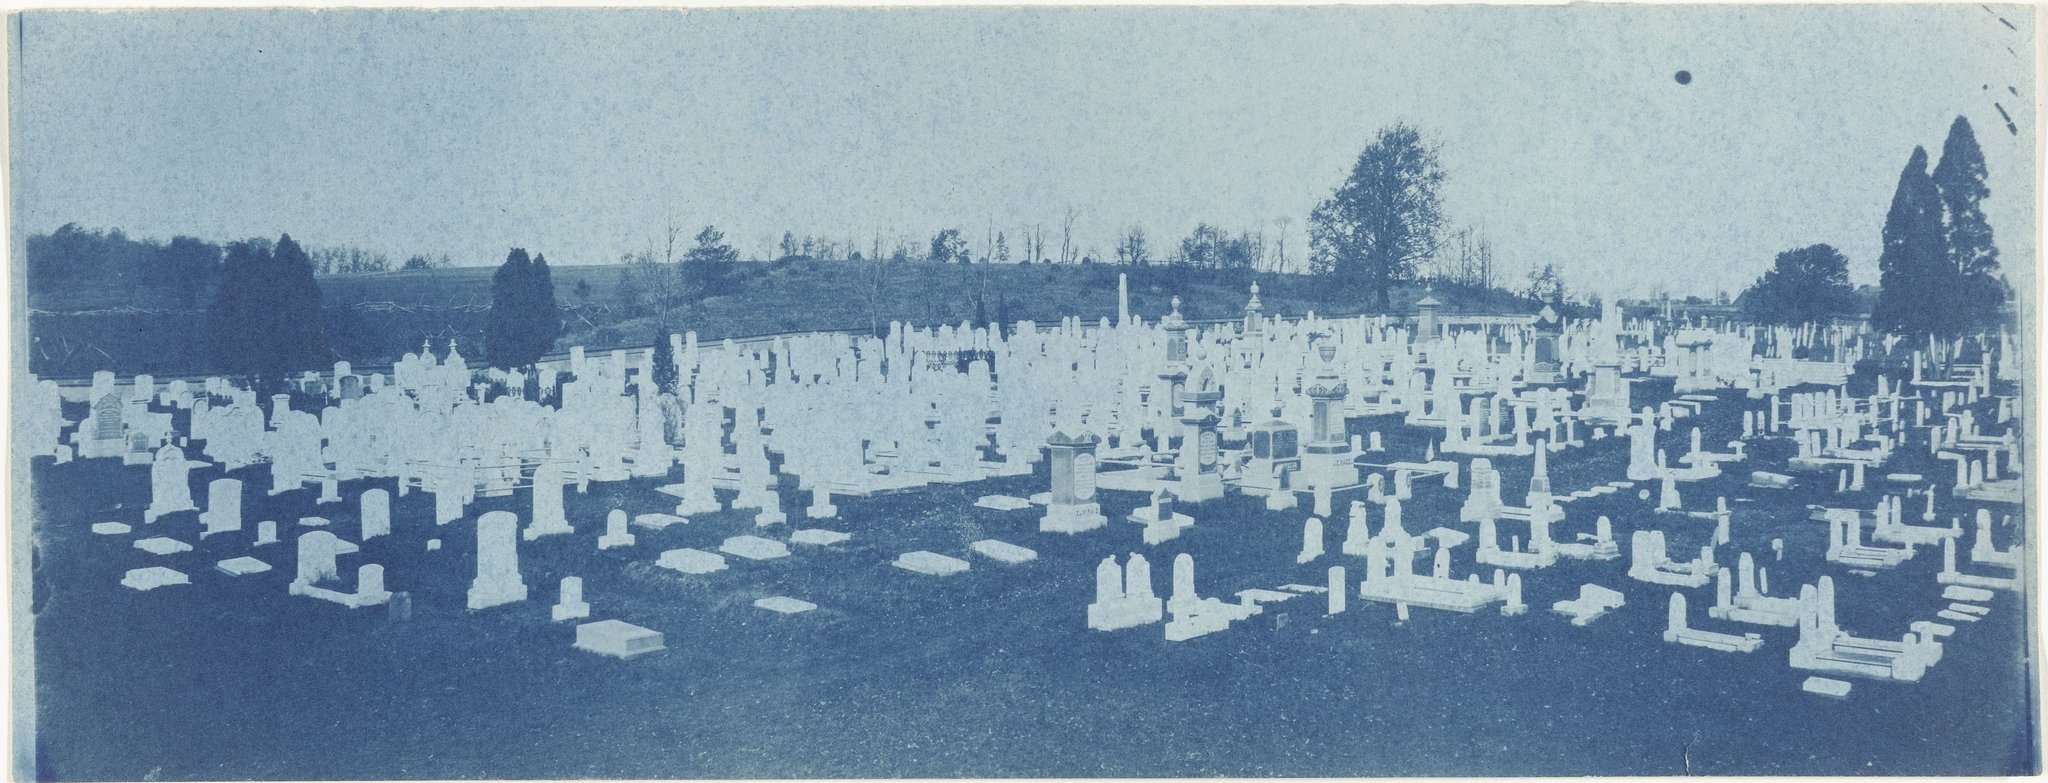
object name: photograph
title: Begraafplaats te Bath, Pennsylvania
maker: w.d. walter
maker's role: fotograaf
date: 1890-1920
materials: paper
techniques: cyanotype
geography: bath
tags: churchyard, cemetery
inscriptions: signature: ‘Negative No......... / W.D. Walter. Artist. / ARCHITECTURAL VIEWS. / Landscapes Groups & Portraits / 187 MAIN ST, BATH PA.’